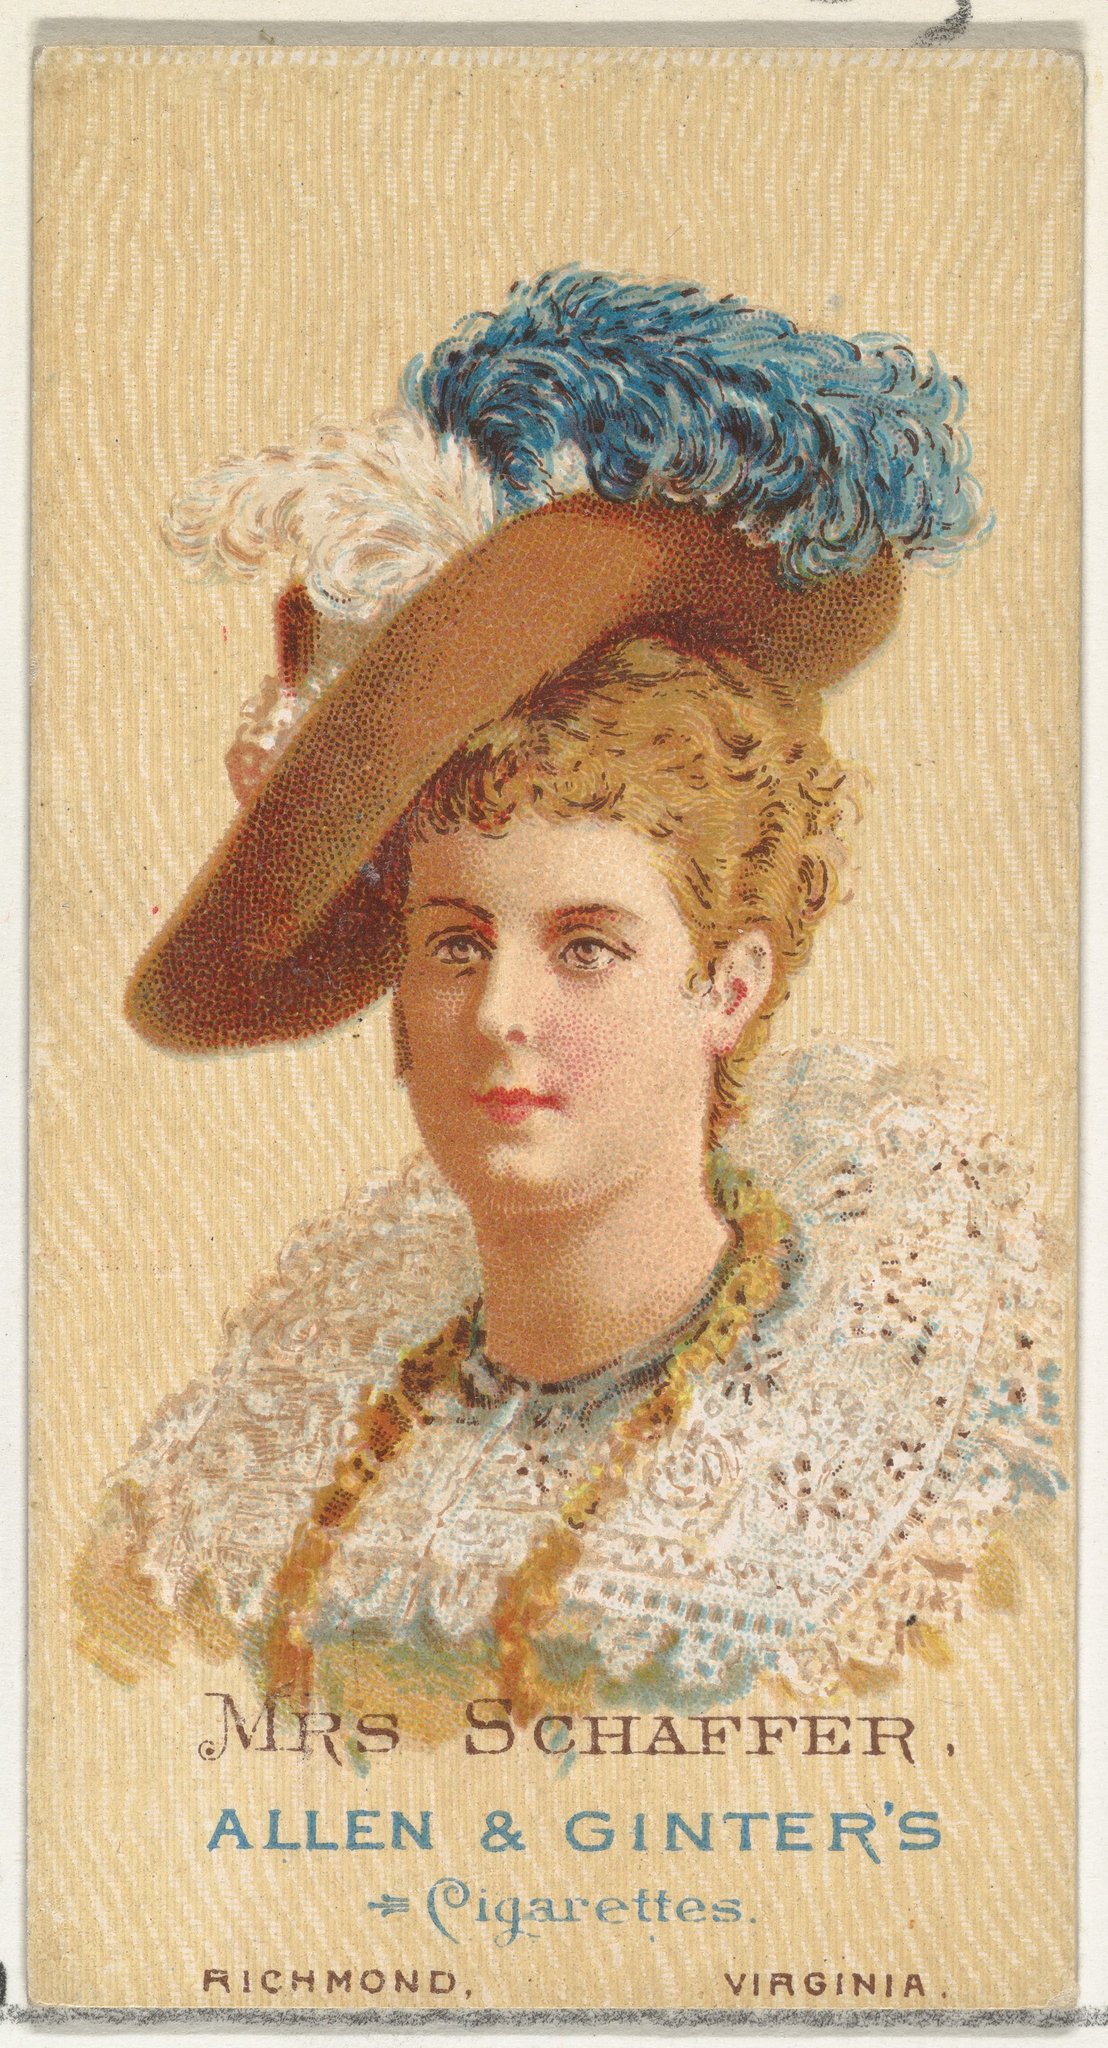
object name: print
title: Mrs. Schaffer, from World's Beauties, Series 2 (N27) for Allen & Ginter Cigarettes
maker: allen & ginter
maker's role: publisher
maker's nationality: american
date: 1888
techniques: color lithograph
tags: women